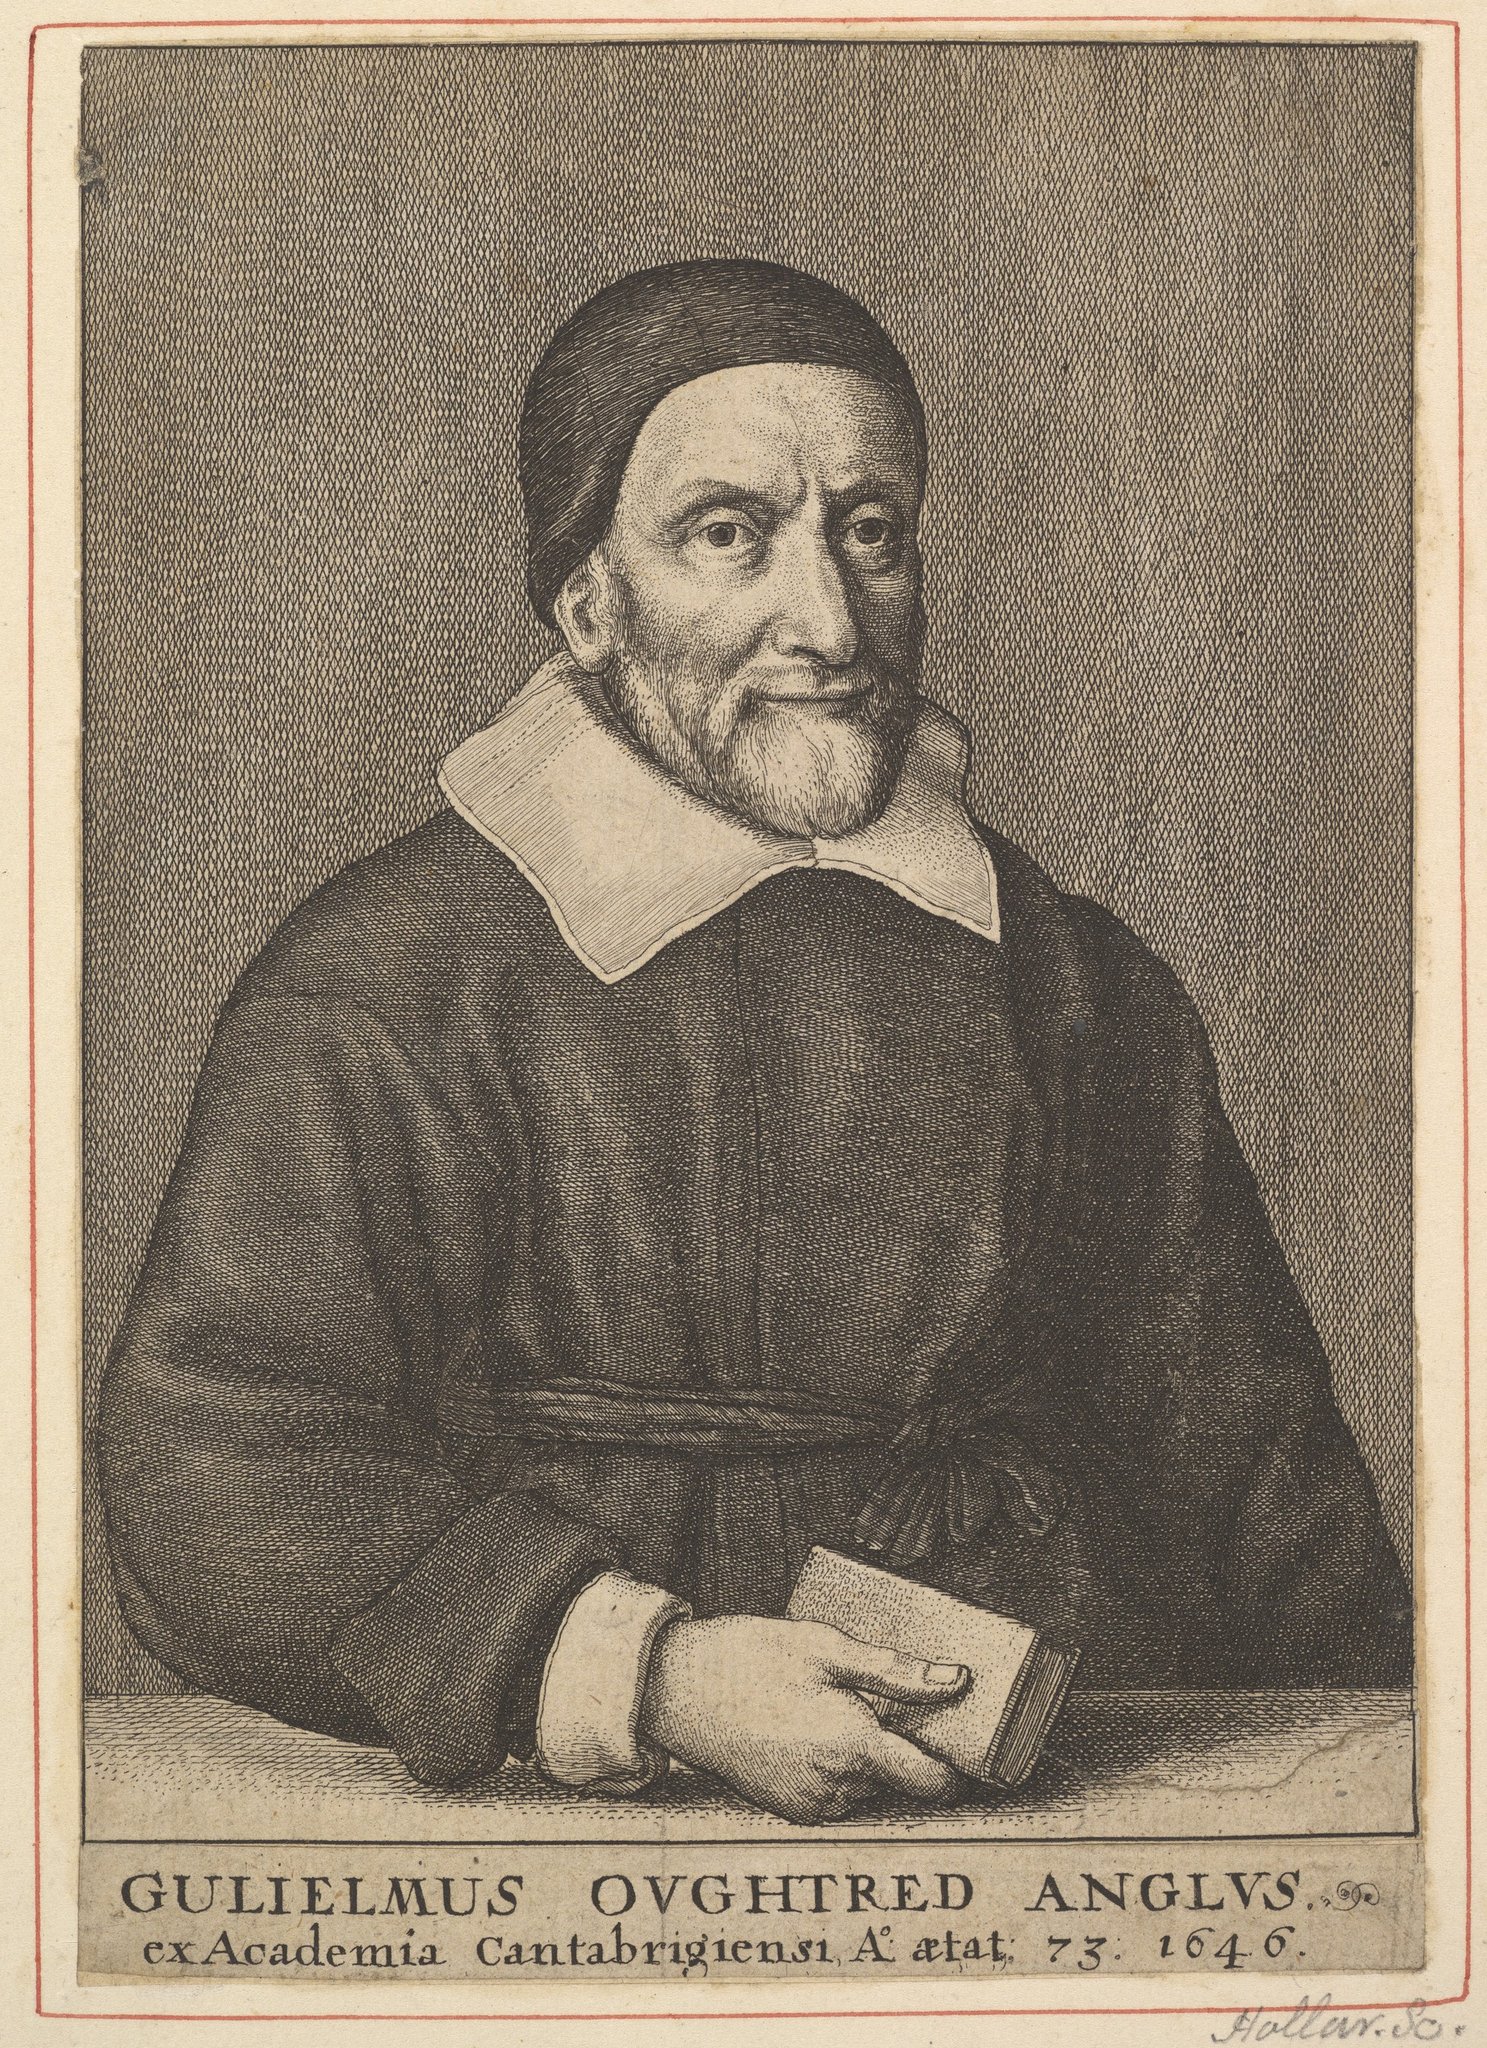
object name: print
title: Gulielmus Oughtred Anglus (frontispiece from Oughtred's "The Key of the Mathematicks New Forged and Filed," 1647)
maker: wenceslaus hollar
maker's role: artist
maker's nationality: bohemian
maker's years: 1607-1677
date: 1646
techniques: drypoint, etching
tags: men,portraits